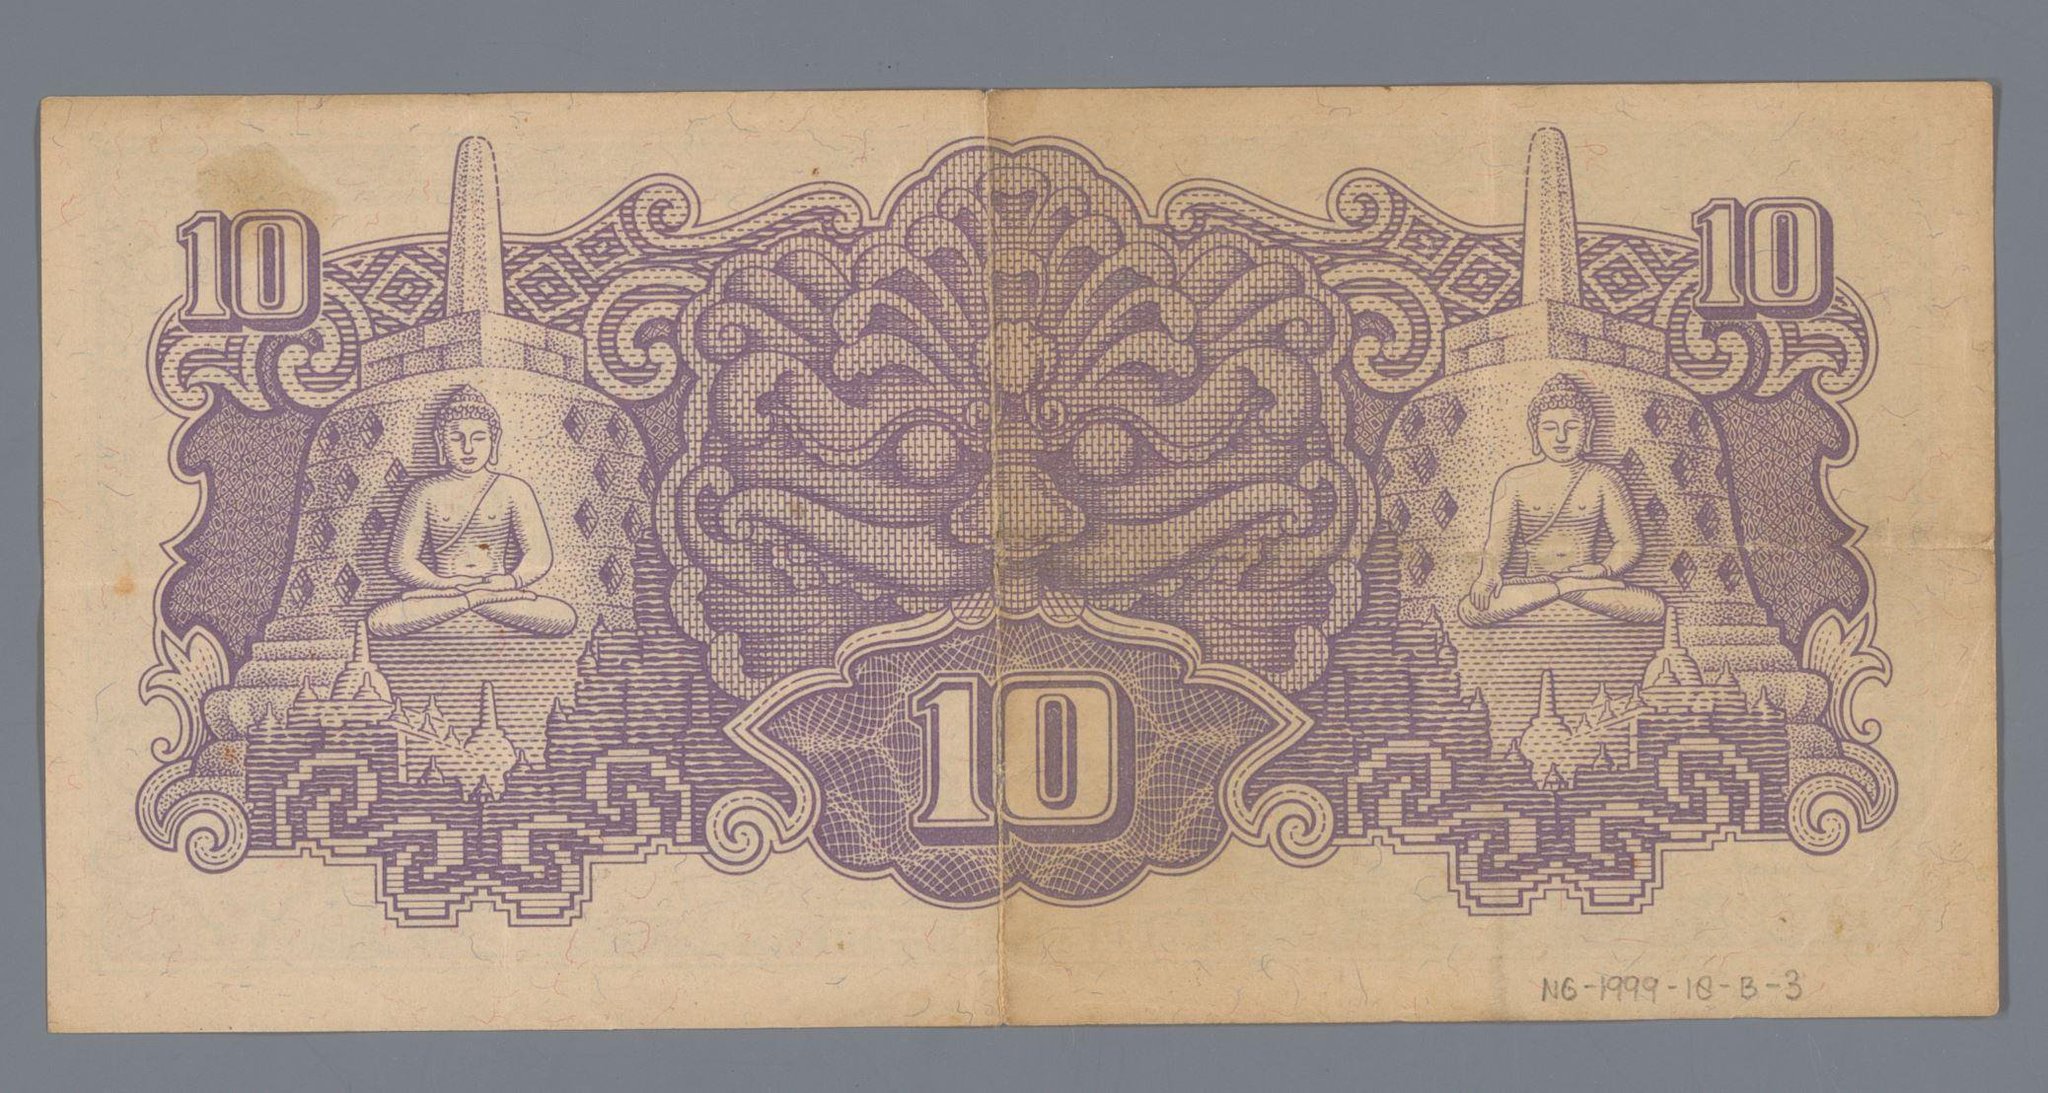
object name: bank note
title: Bankbiljet van tien roepiah, uitgegeven door de Japanse regering tijdens de bezetting van Nederlands-Indië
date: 1940-1945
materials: ink, paper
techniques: printing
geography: dutch east indies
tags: dutch east indies, the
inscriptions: inscription: ‘DAI NIPPON TEIKOKU / SEIHU / SPOELOEH / ROEPIAH’, mark: ‘SL’, inscription: ‘10’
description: Bankbiljet uit Nederlands-Indië van tien roepiah. Voorzijde: in zwart en oker bedrukt met opschrift. Versierde rand waar In het midden een zittende man met hoofddeksel en aan zijn linkerzijde een dolk. Keerzijde: in paars gedrukt met links en rechts vrijwel identiek figuren met benen in kleermakerszit.